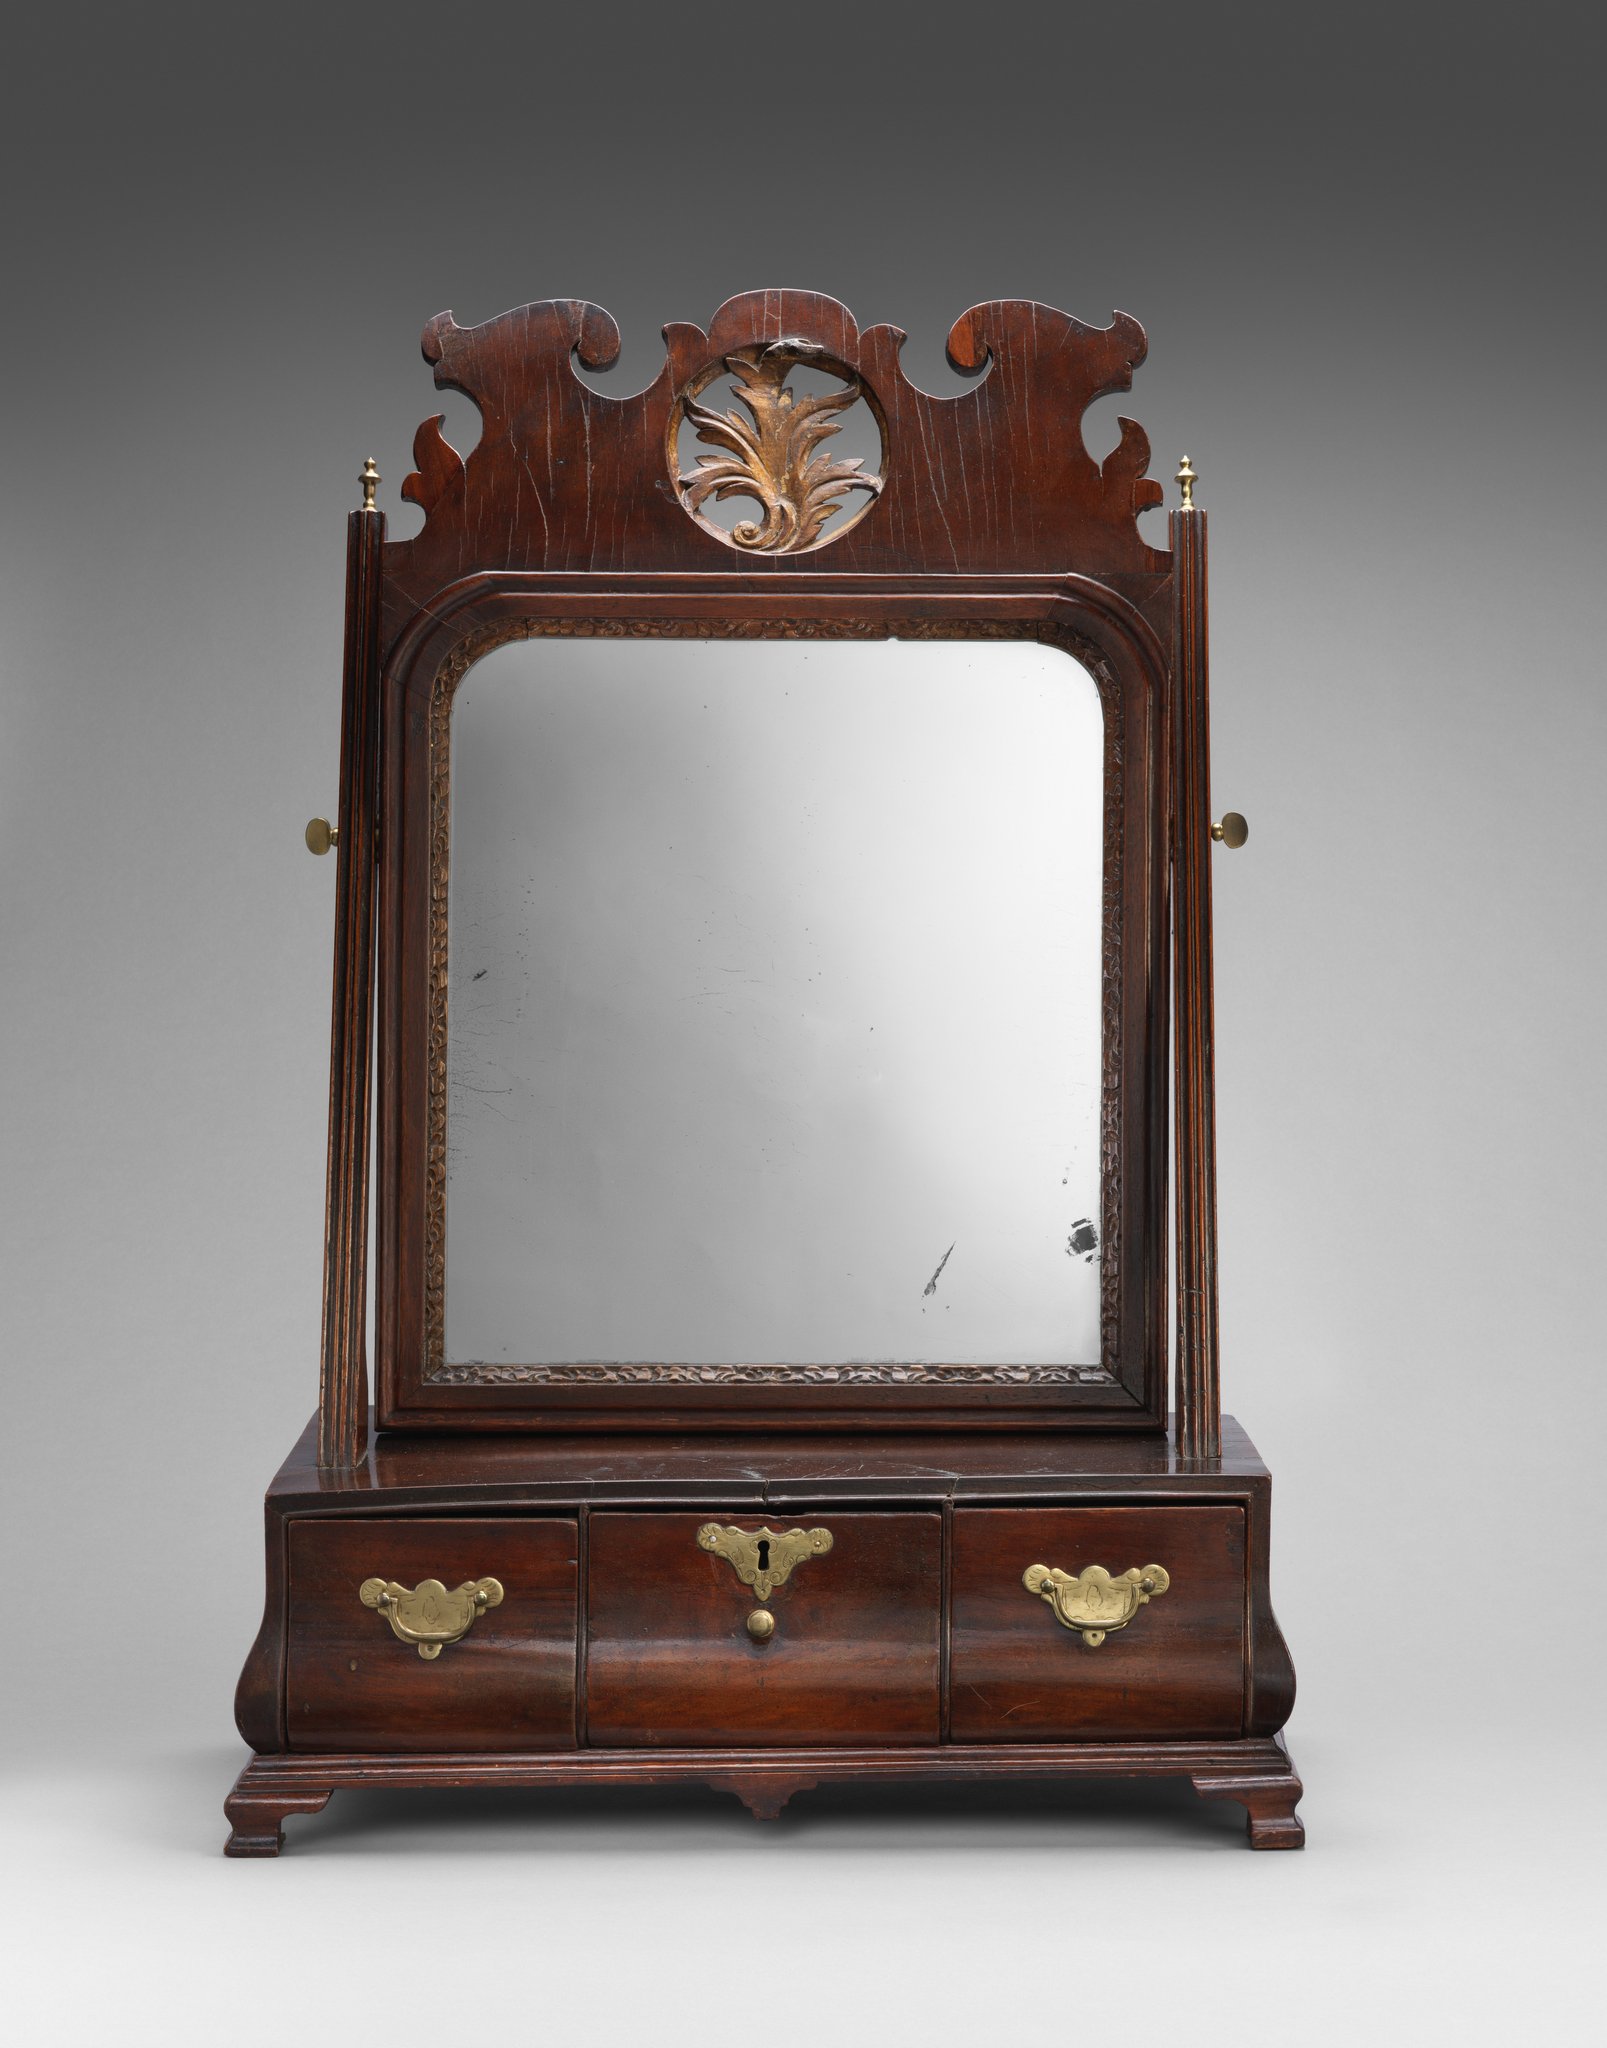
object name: dressing glass and box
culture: american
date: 1760-1790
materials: brass, glass, wood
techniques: veneering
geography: united states